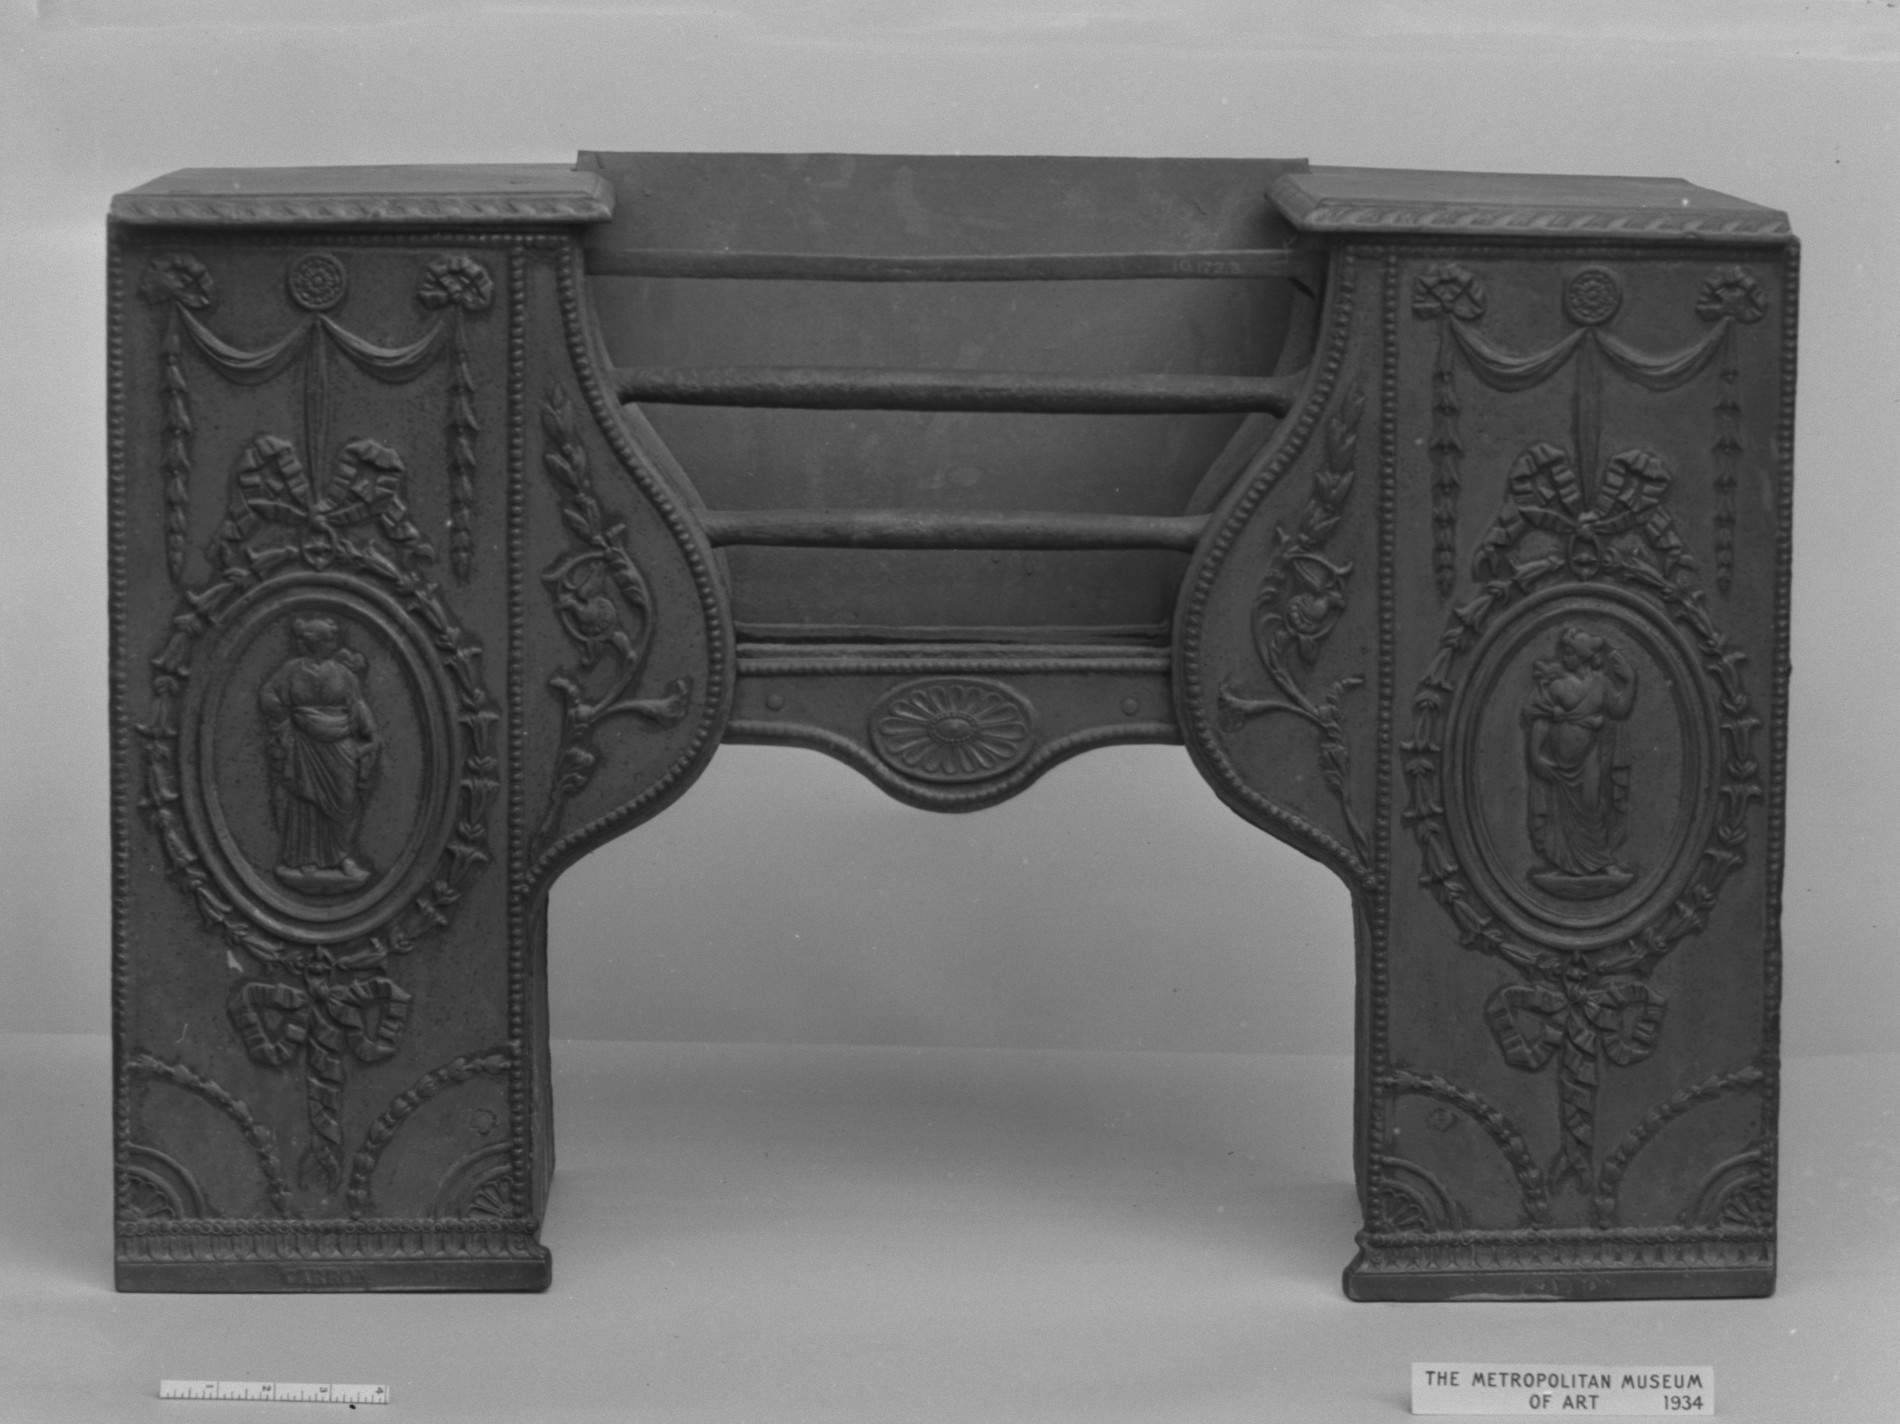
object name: hob grate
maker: carron foundry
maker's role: manufacturer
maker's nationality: scottish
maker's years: 1759-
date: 1751-1775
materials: iron